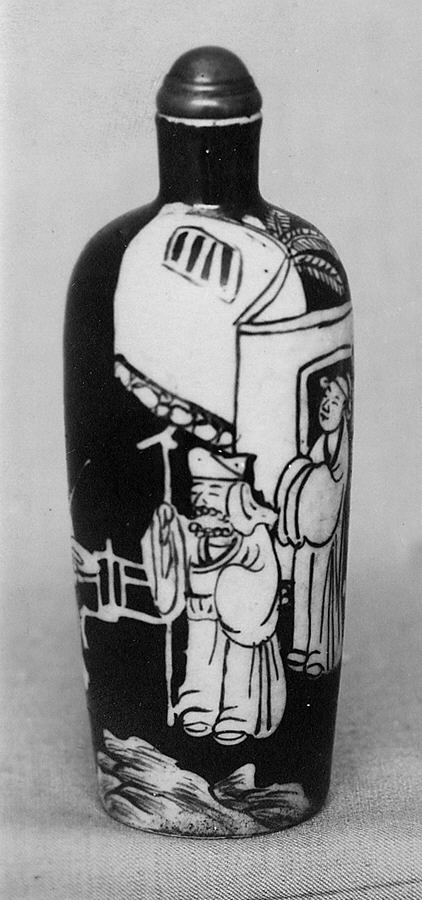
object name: snuff bottle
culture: chinese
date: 1723-1735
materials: porcelain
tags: human figures